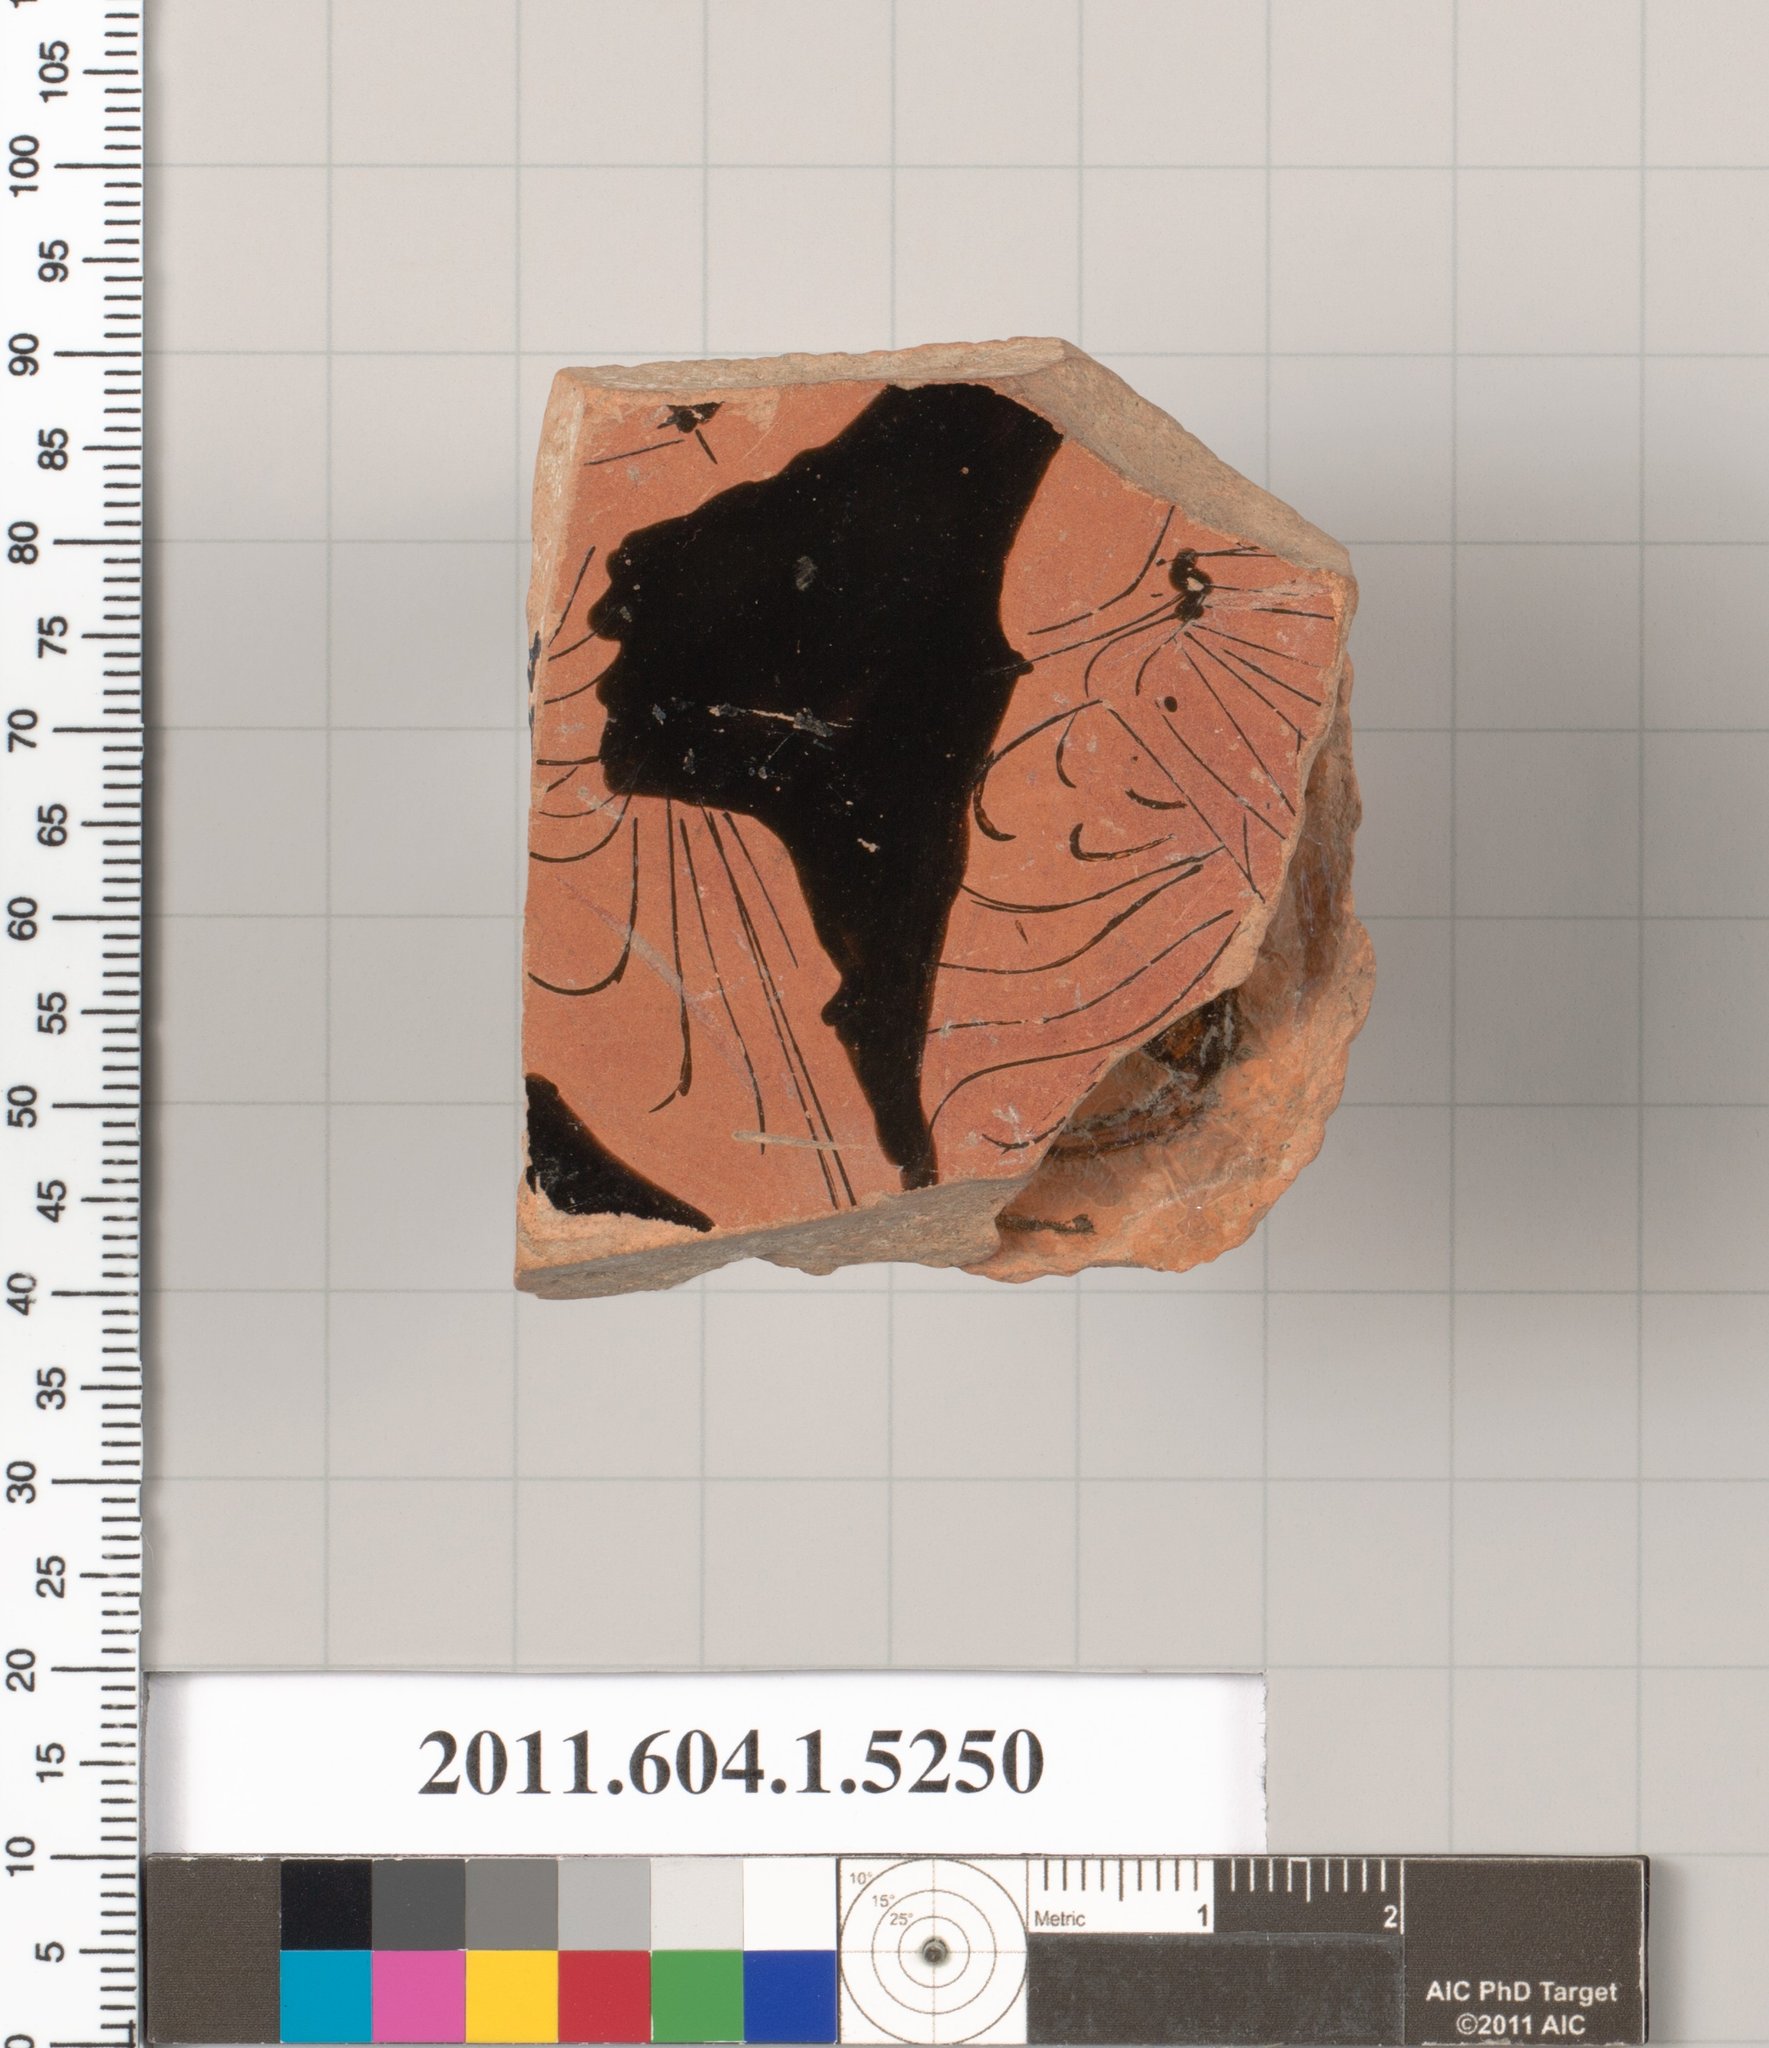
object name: kylix fragment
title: Terracotta fragment of a kylix (drinking cup)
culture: greek, attic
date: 467-435 BCE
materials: terracotta